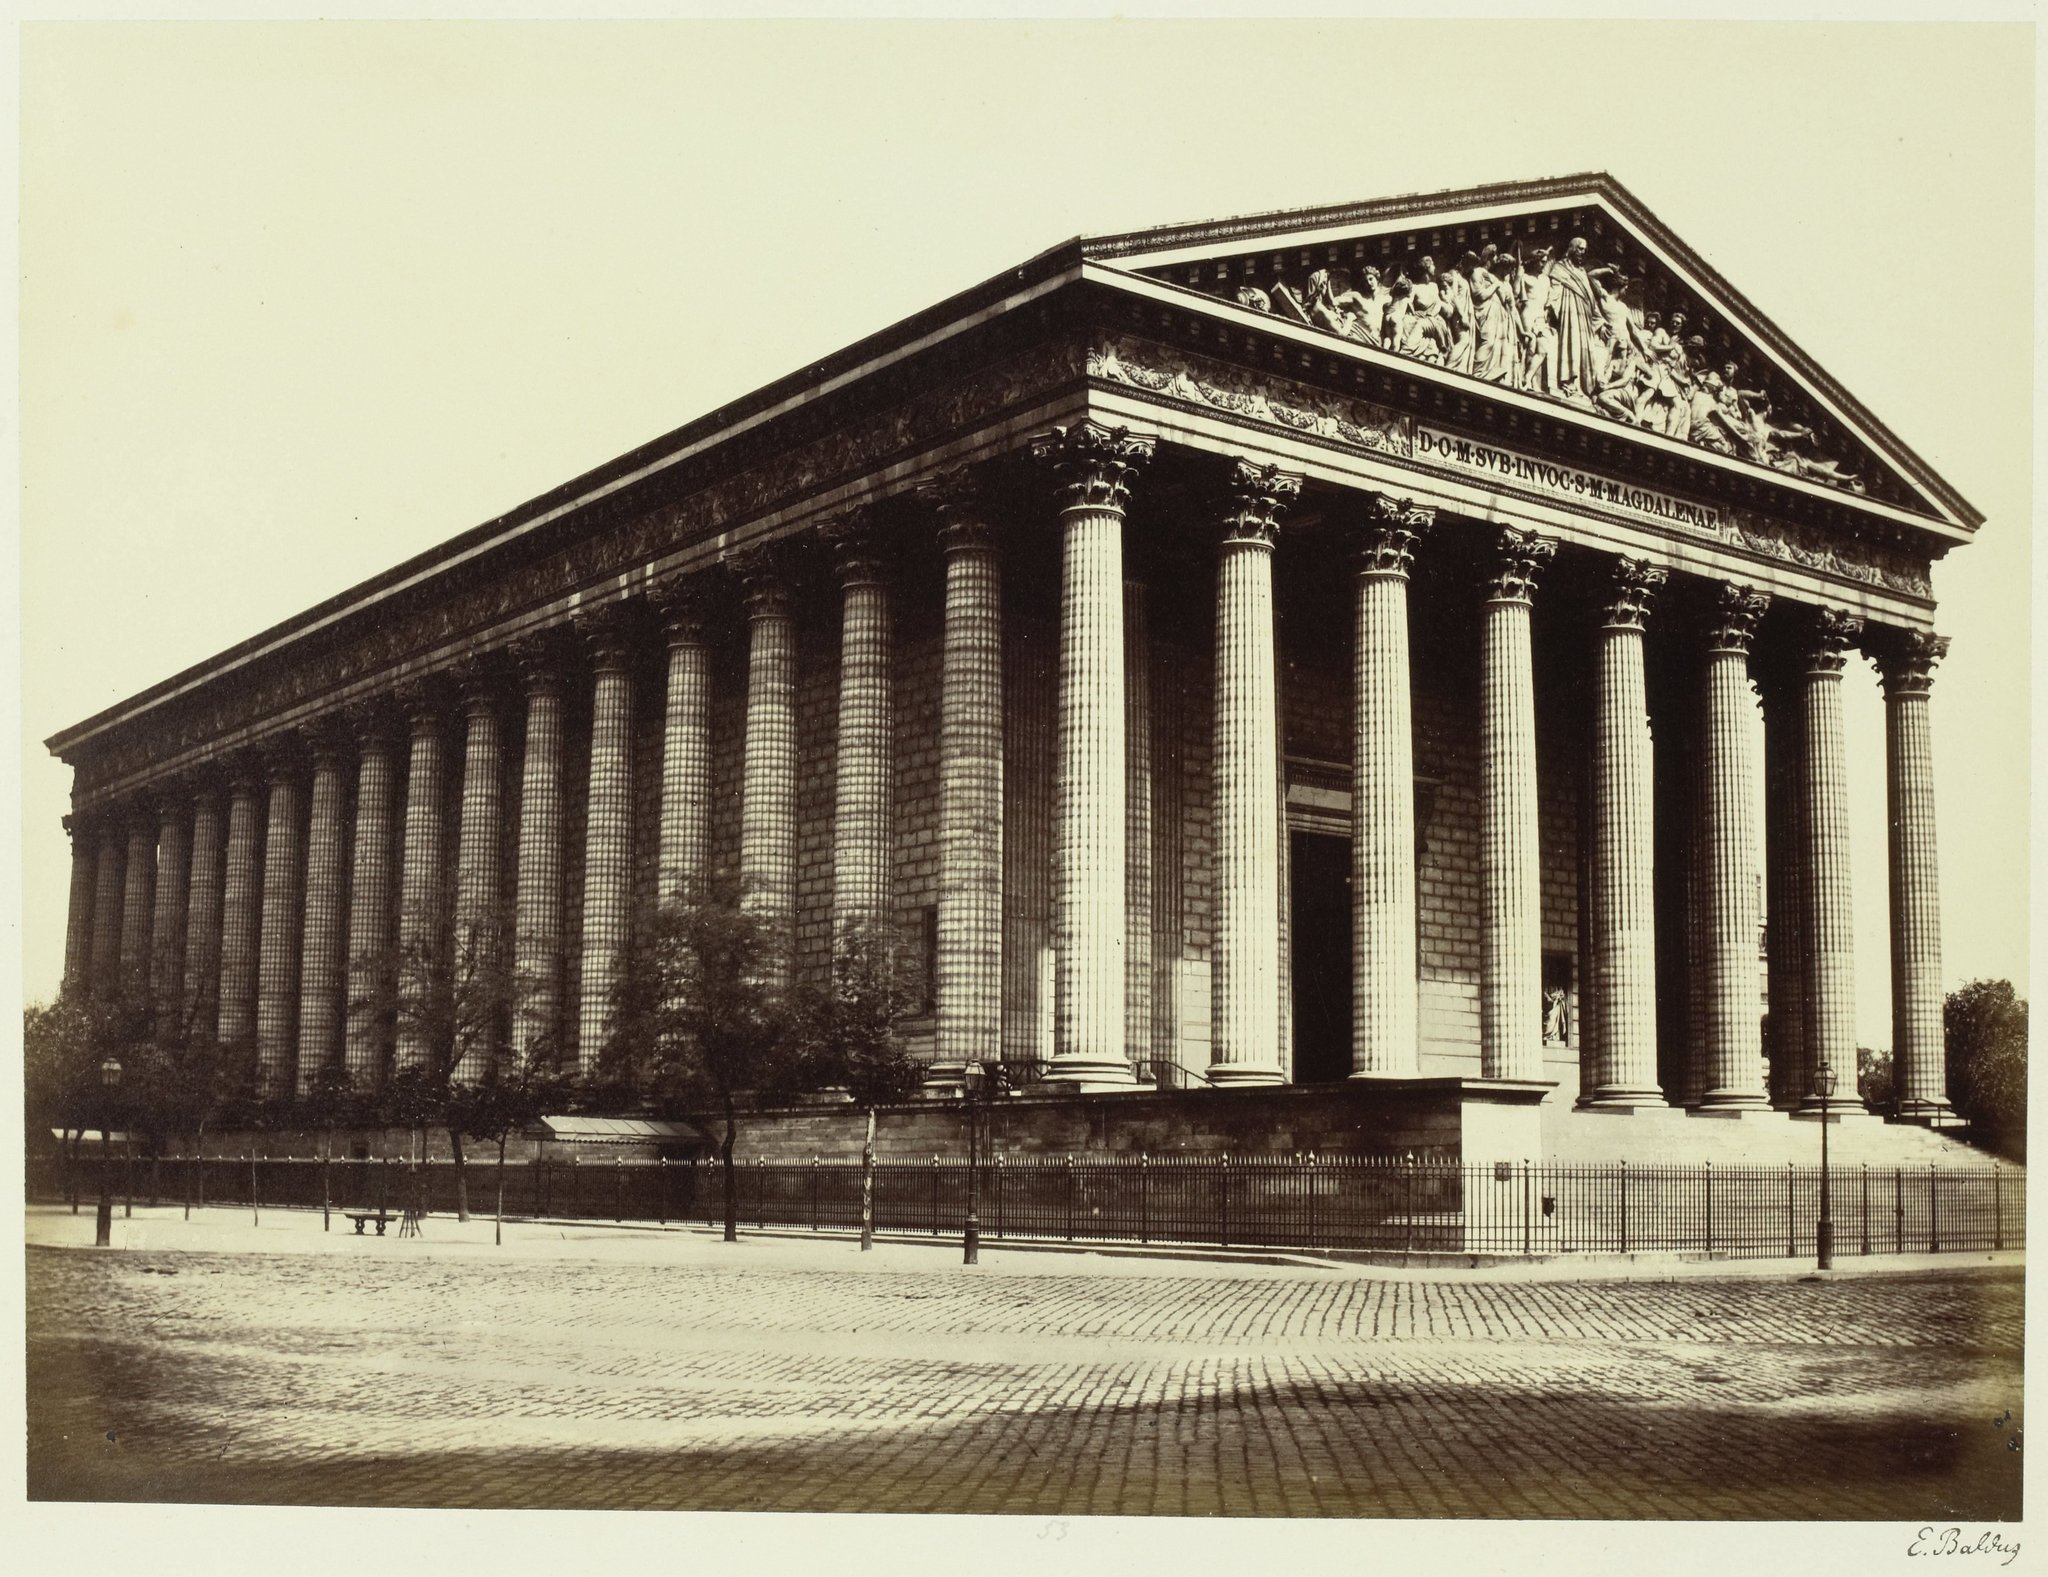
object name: photograph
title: La Madeleine, Parijs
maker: édouard denis baldus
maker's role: fotograaf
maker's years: 1813-1889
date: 1855-1870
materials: cardboard, paper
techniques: albumen print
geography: paris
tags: church (exterior)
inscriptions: stamp: ‘E. Baldus’, inscription: ‘Rue de la Madeleine’